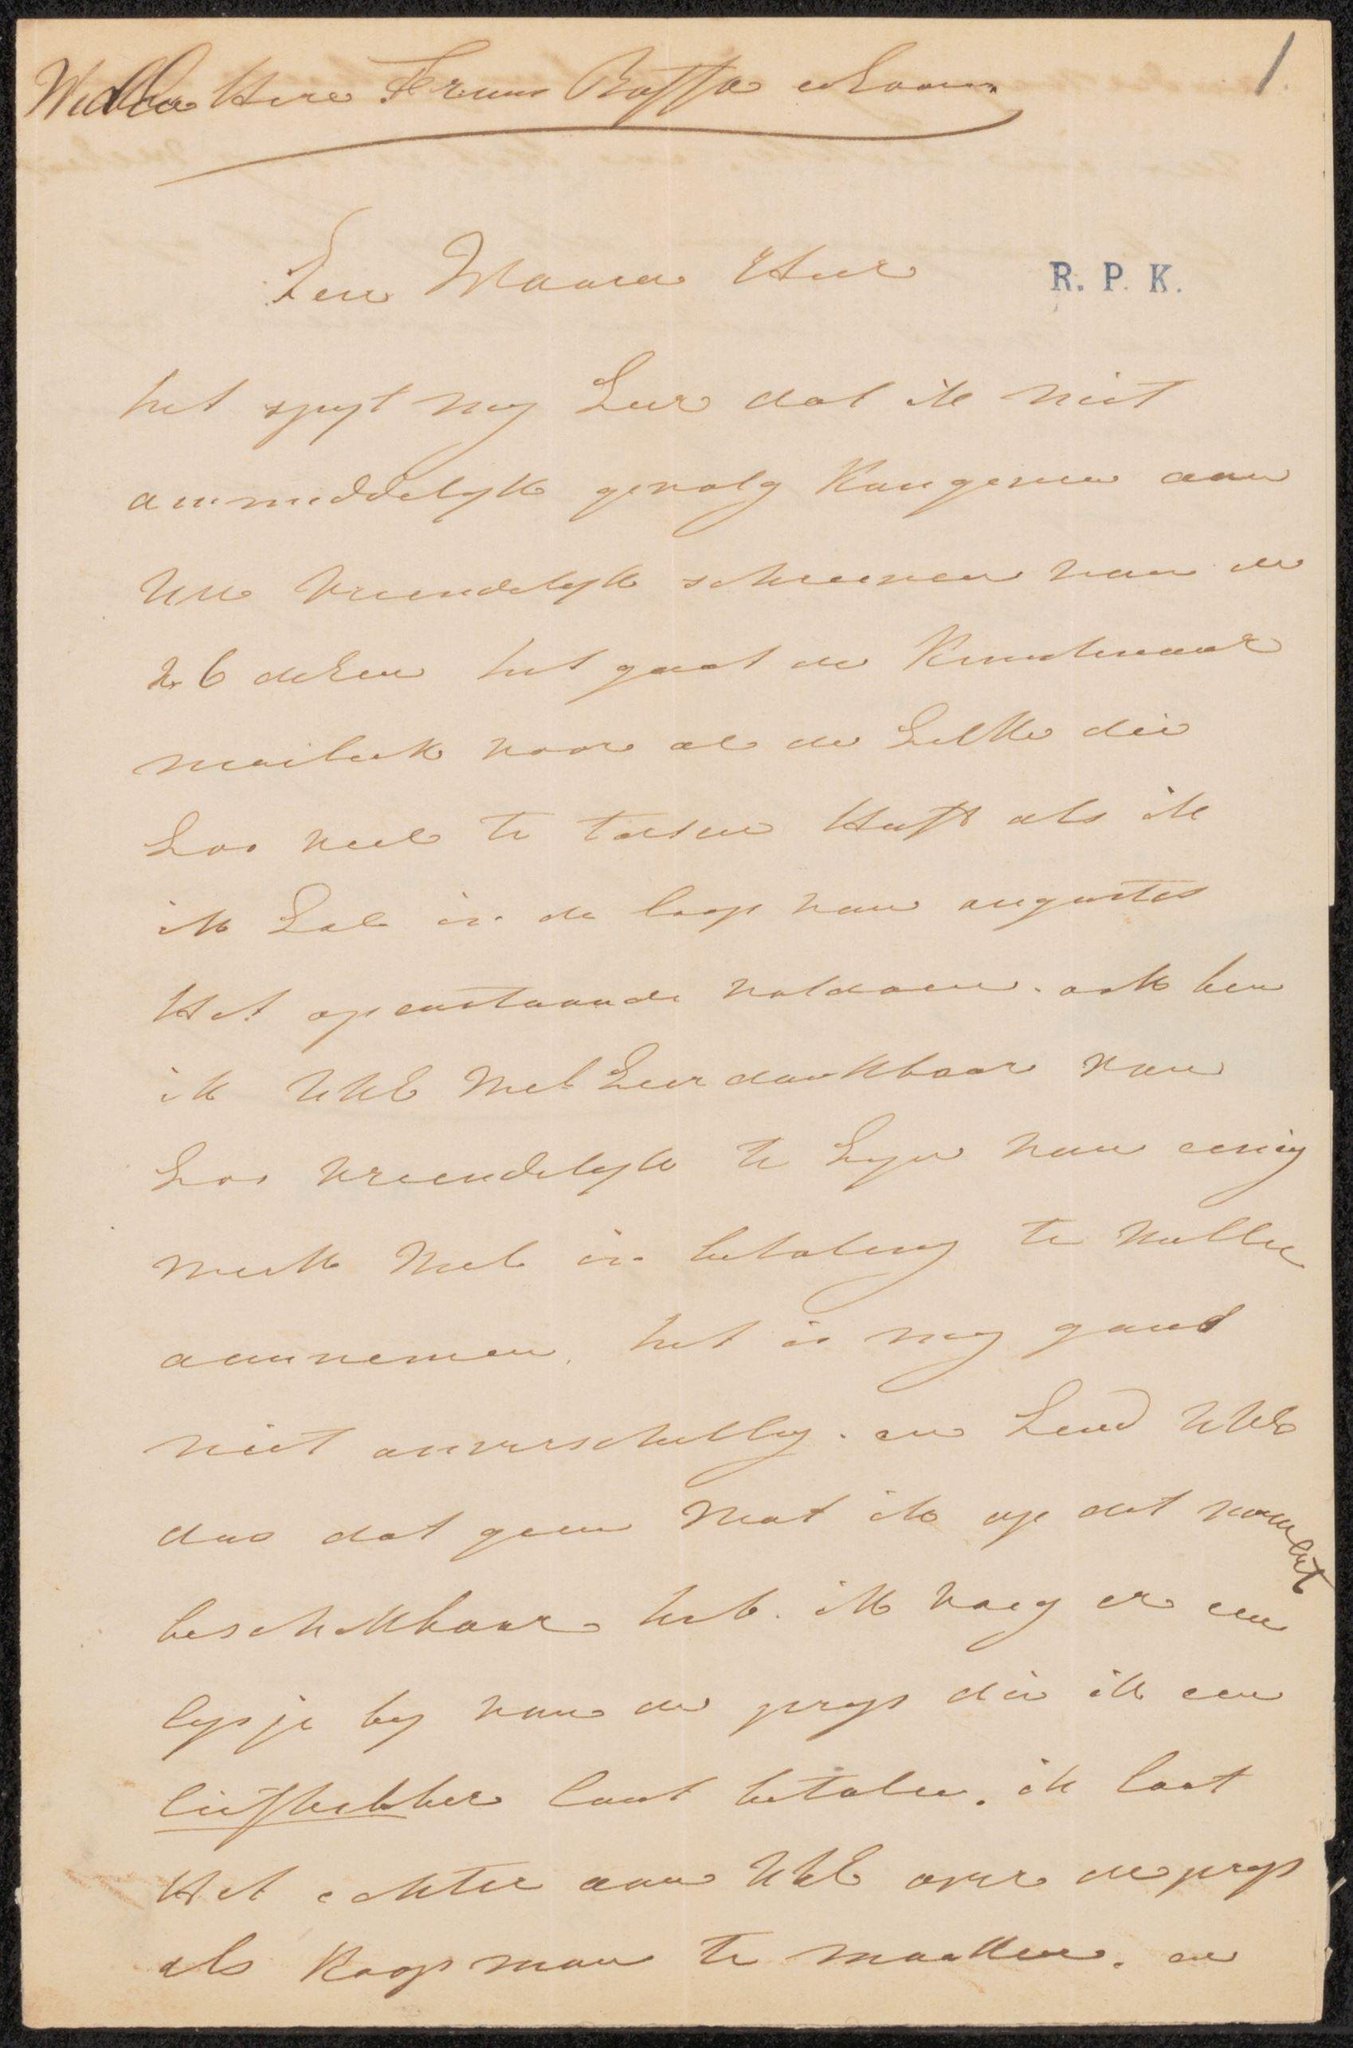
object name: letter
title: Brief aan Alberto Caramelli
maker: johannes hilverdink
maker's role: draughtsman, painter, print maker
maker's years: 1813-1902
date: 1861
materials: ink, paper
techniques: pen, writing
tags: utrecht, publisher, alberto caramelli, art trade, art shop, drawing, money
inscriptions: seal, collector's mark: Lugt 2233